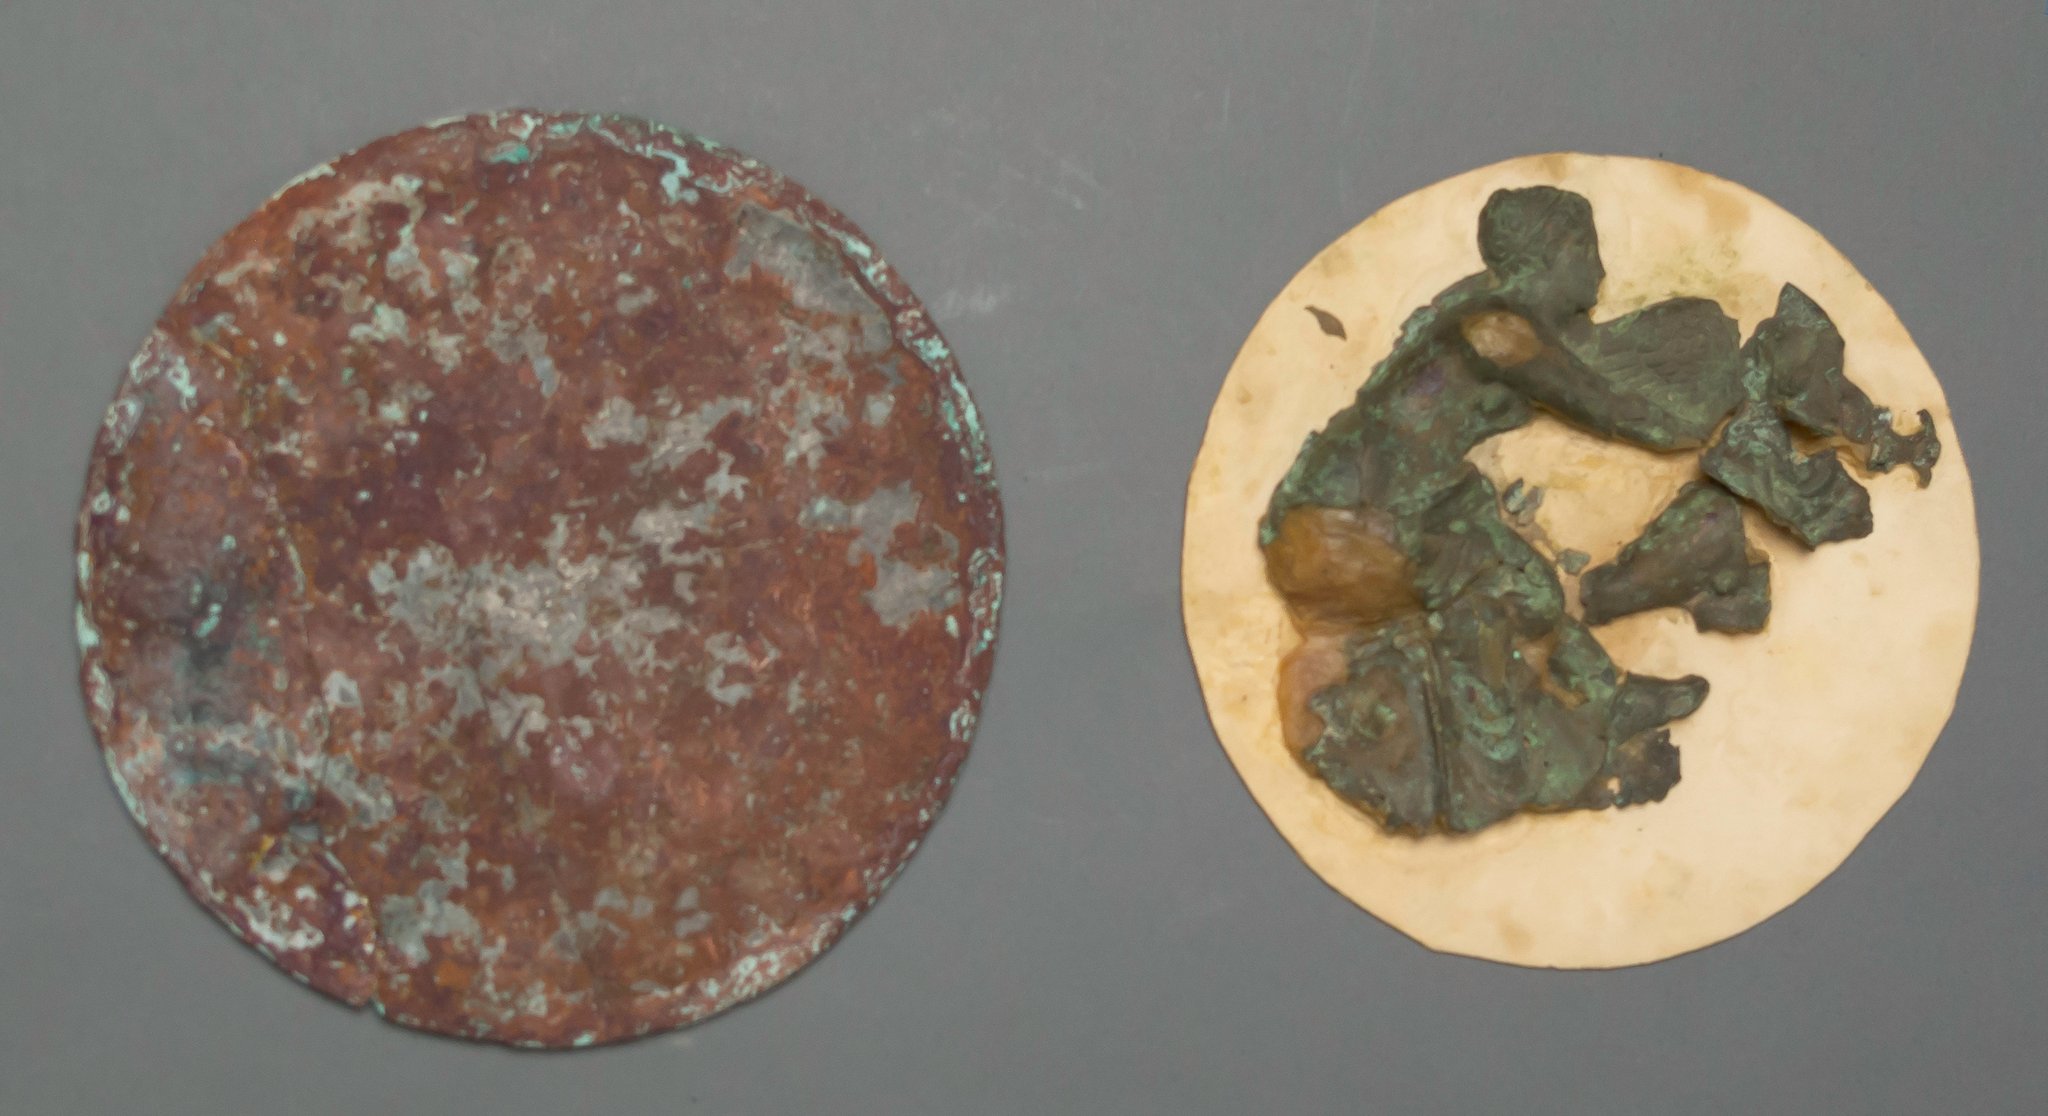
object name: mirror cover, fragmentary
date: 7000 BCE-330 CE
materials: bronze